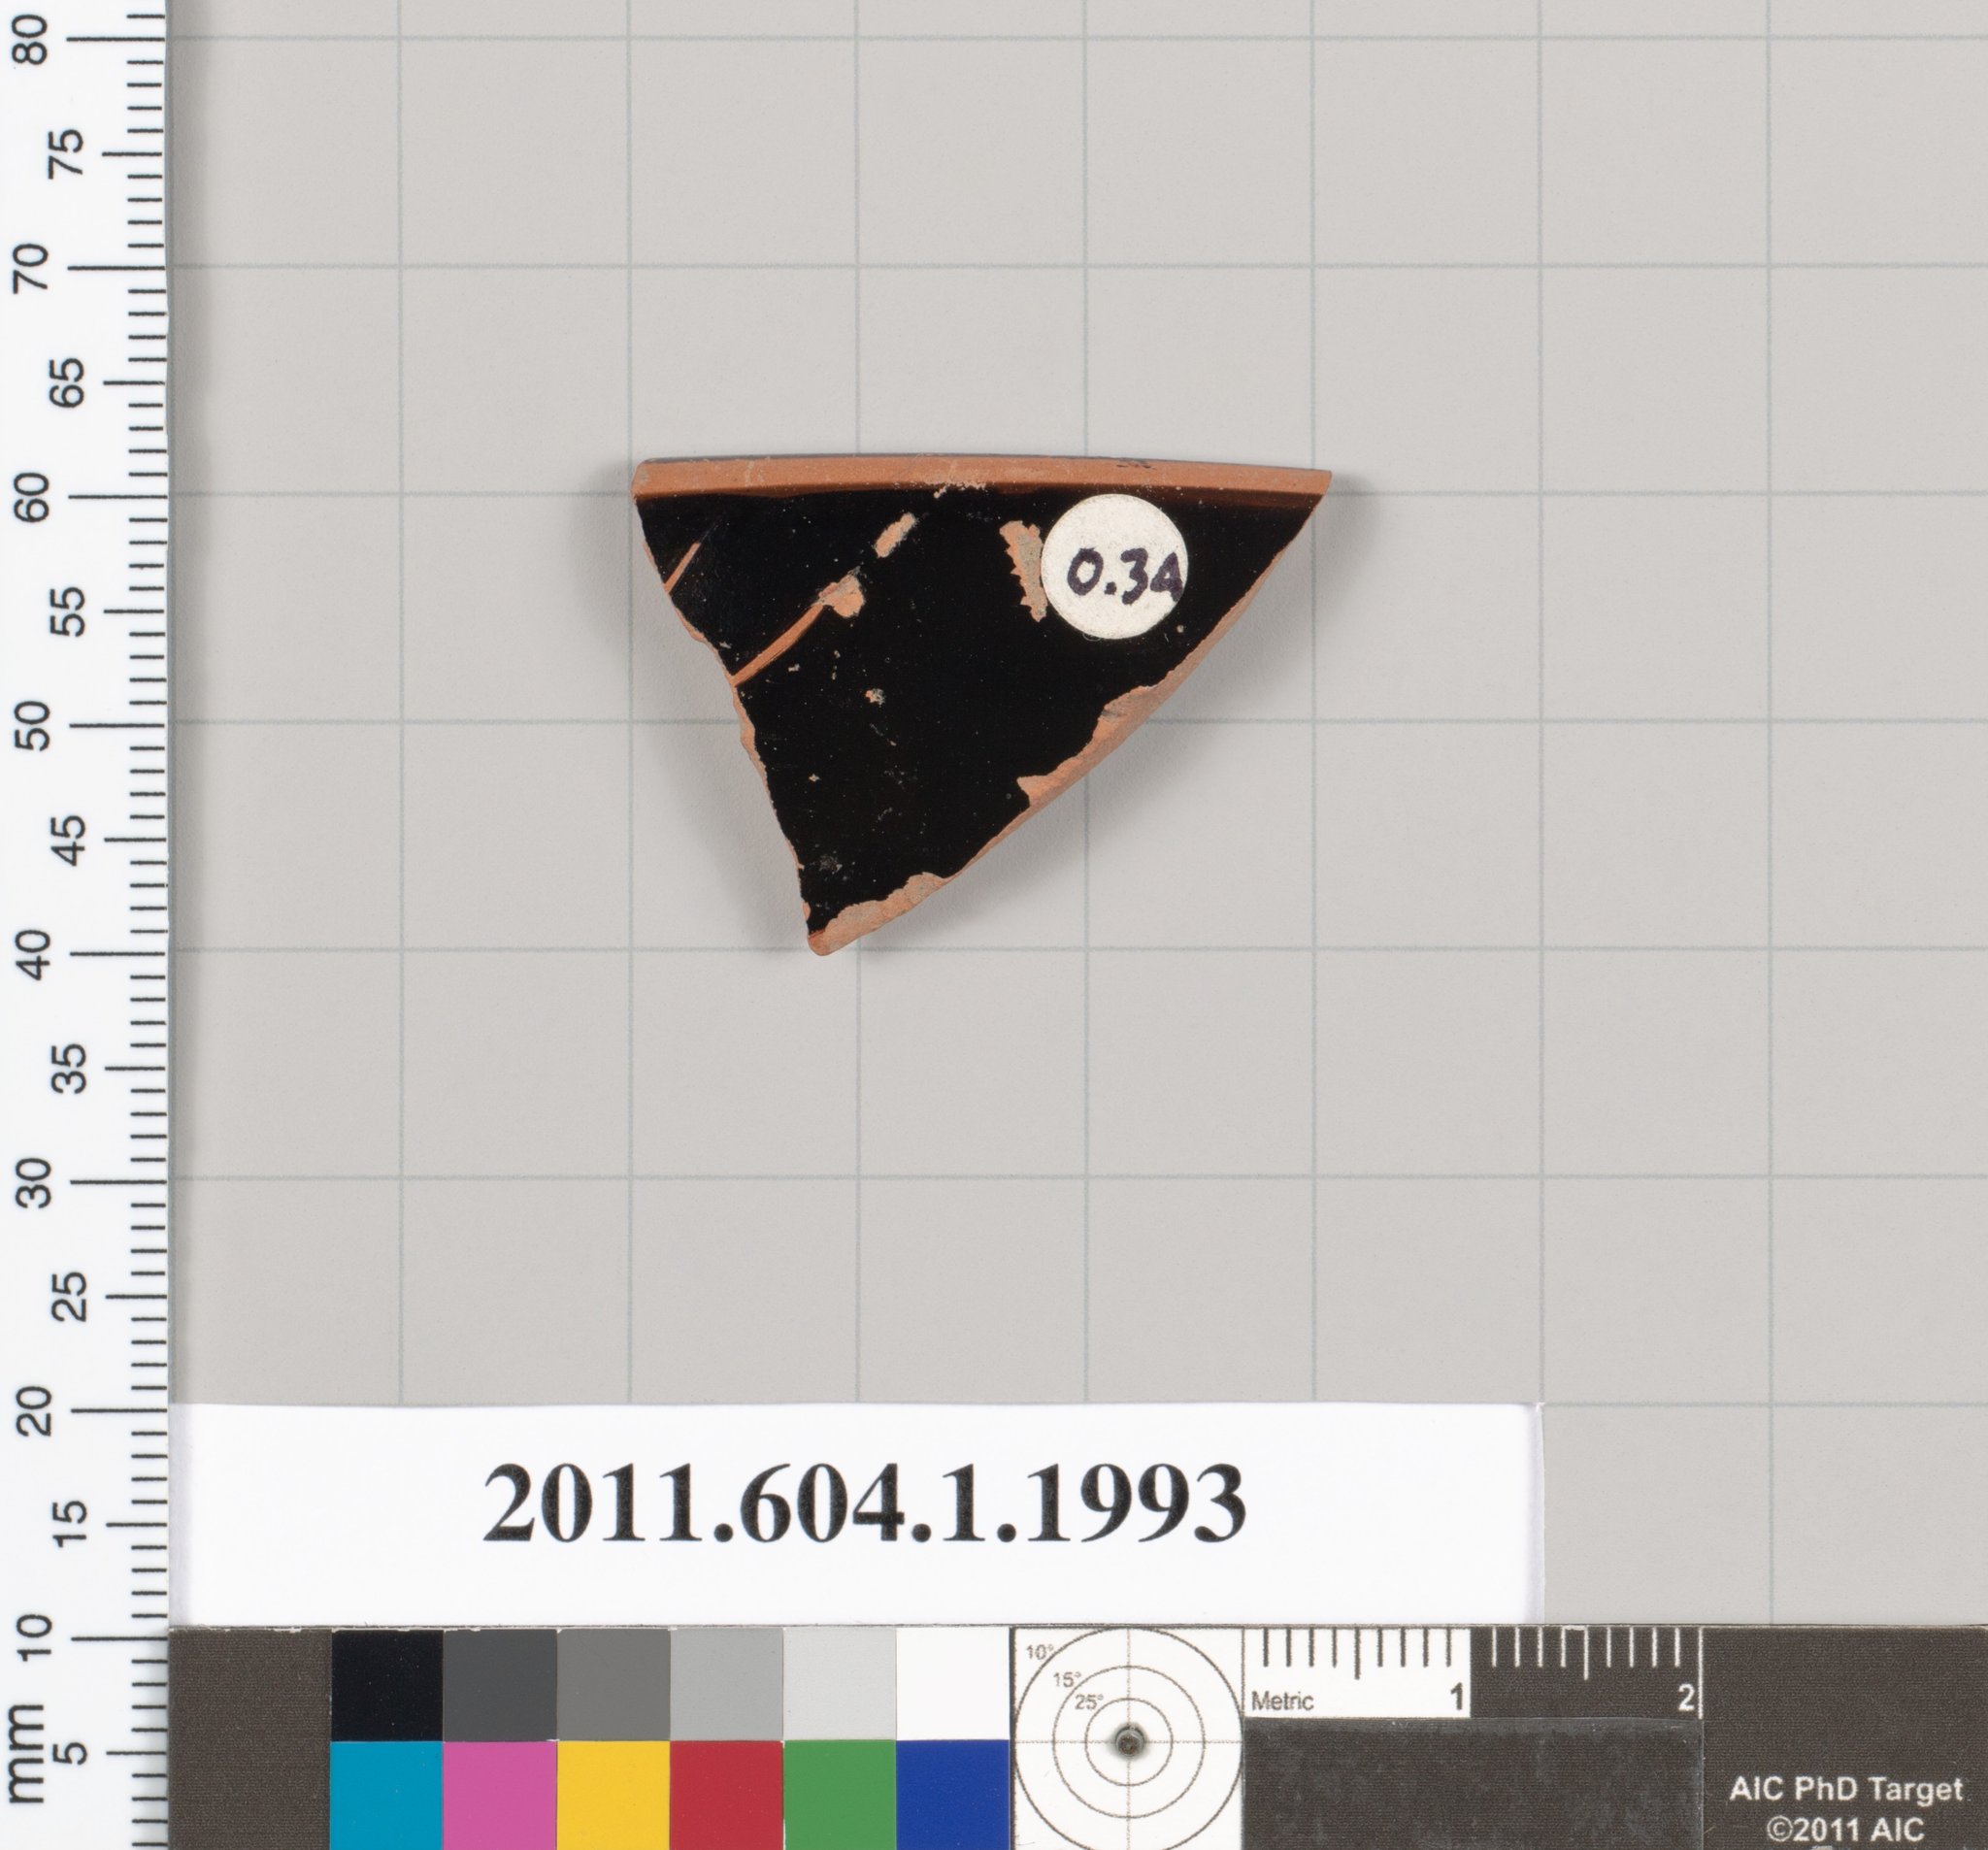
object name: kylix fragment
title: Terracotta rim fragment of a kylix (drinking cup)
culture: greek, attic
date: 475-451 BCE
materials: terracotta